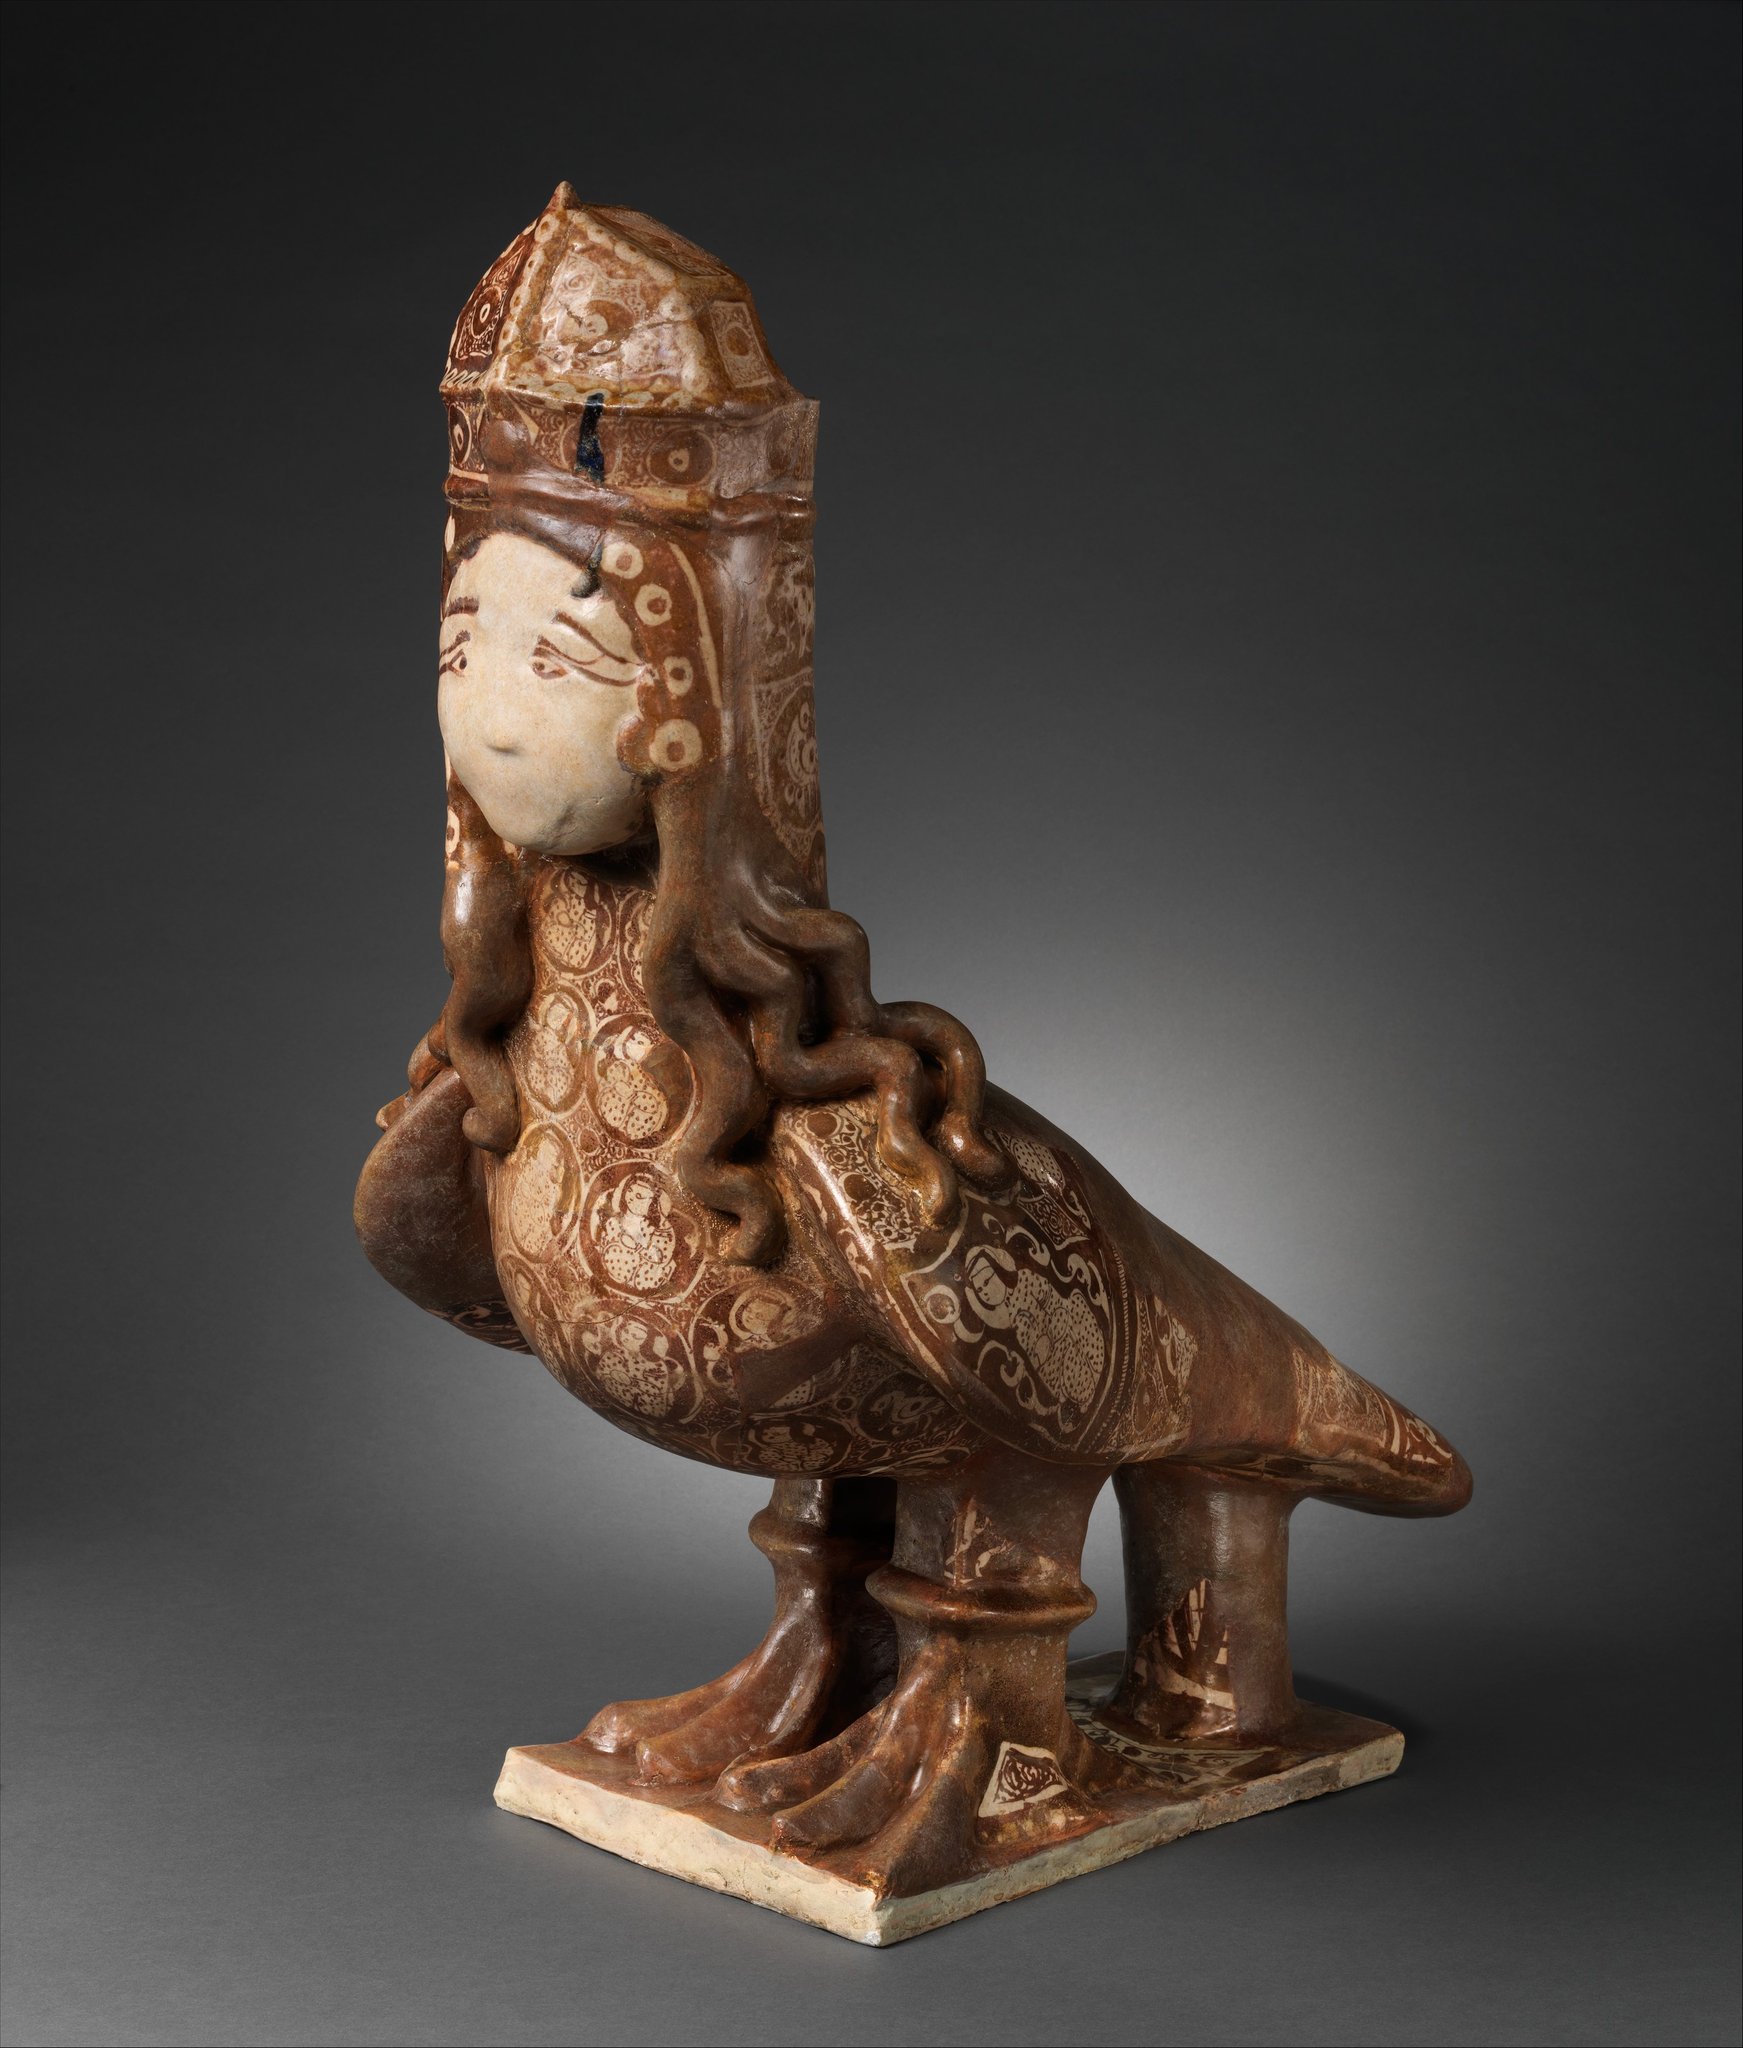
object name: figural vessel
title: Figure of Harpy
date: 1101-1233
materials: glaze, stonepaste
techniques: luster painting, molding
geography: iran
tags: mythical creatures